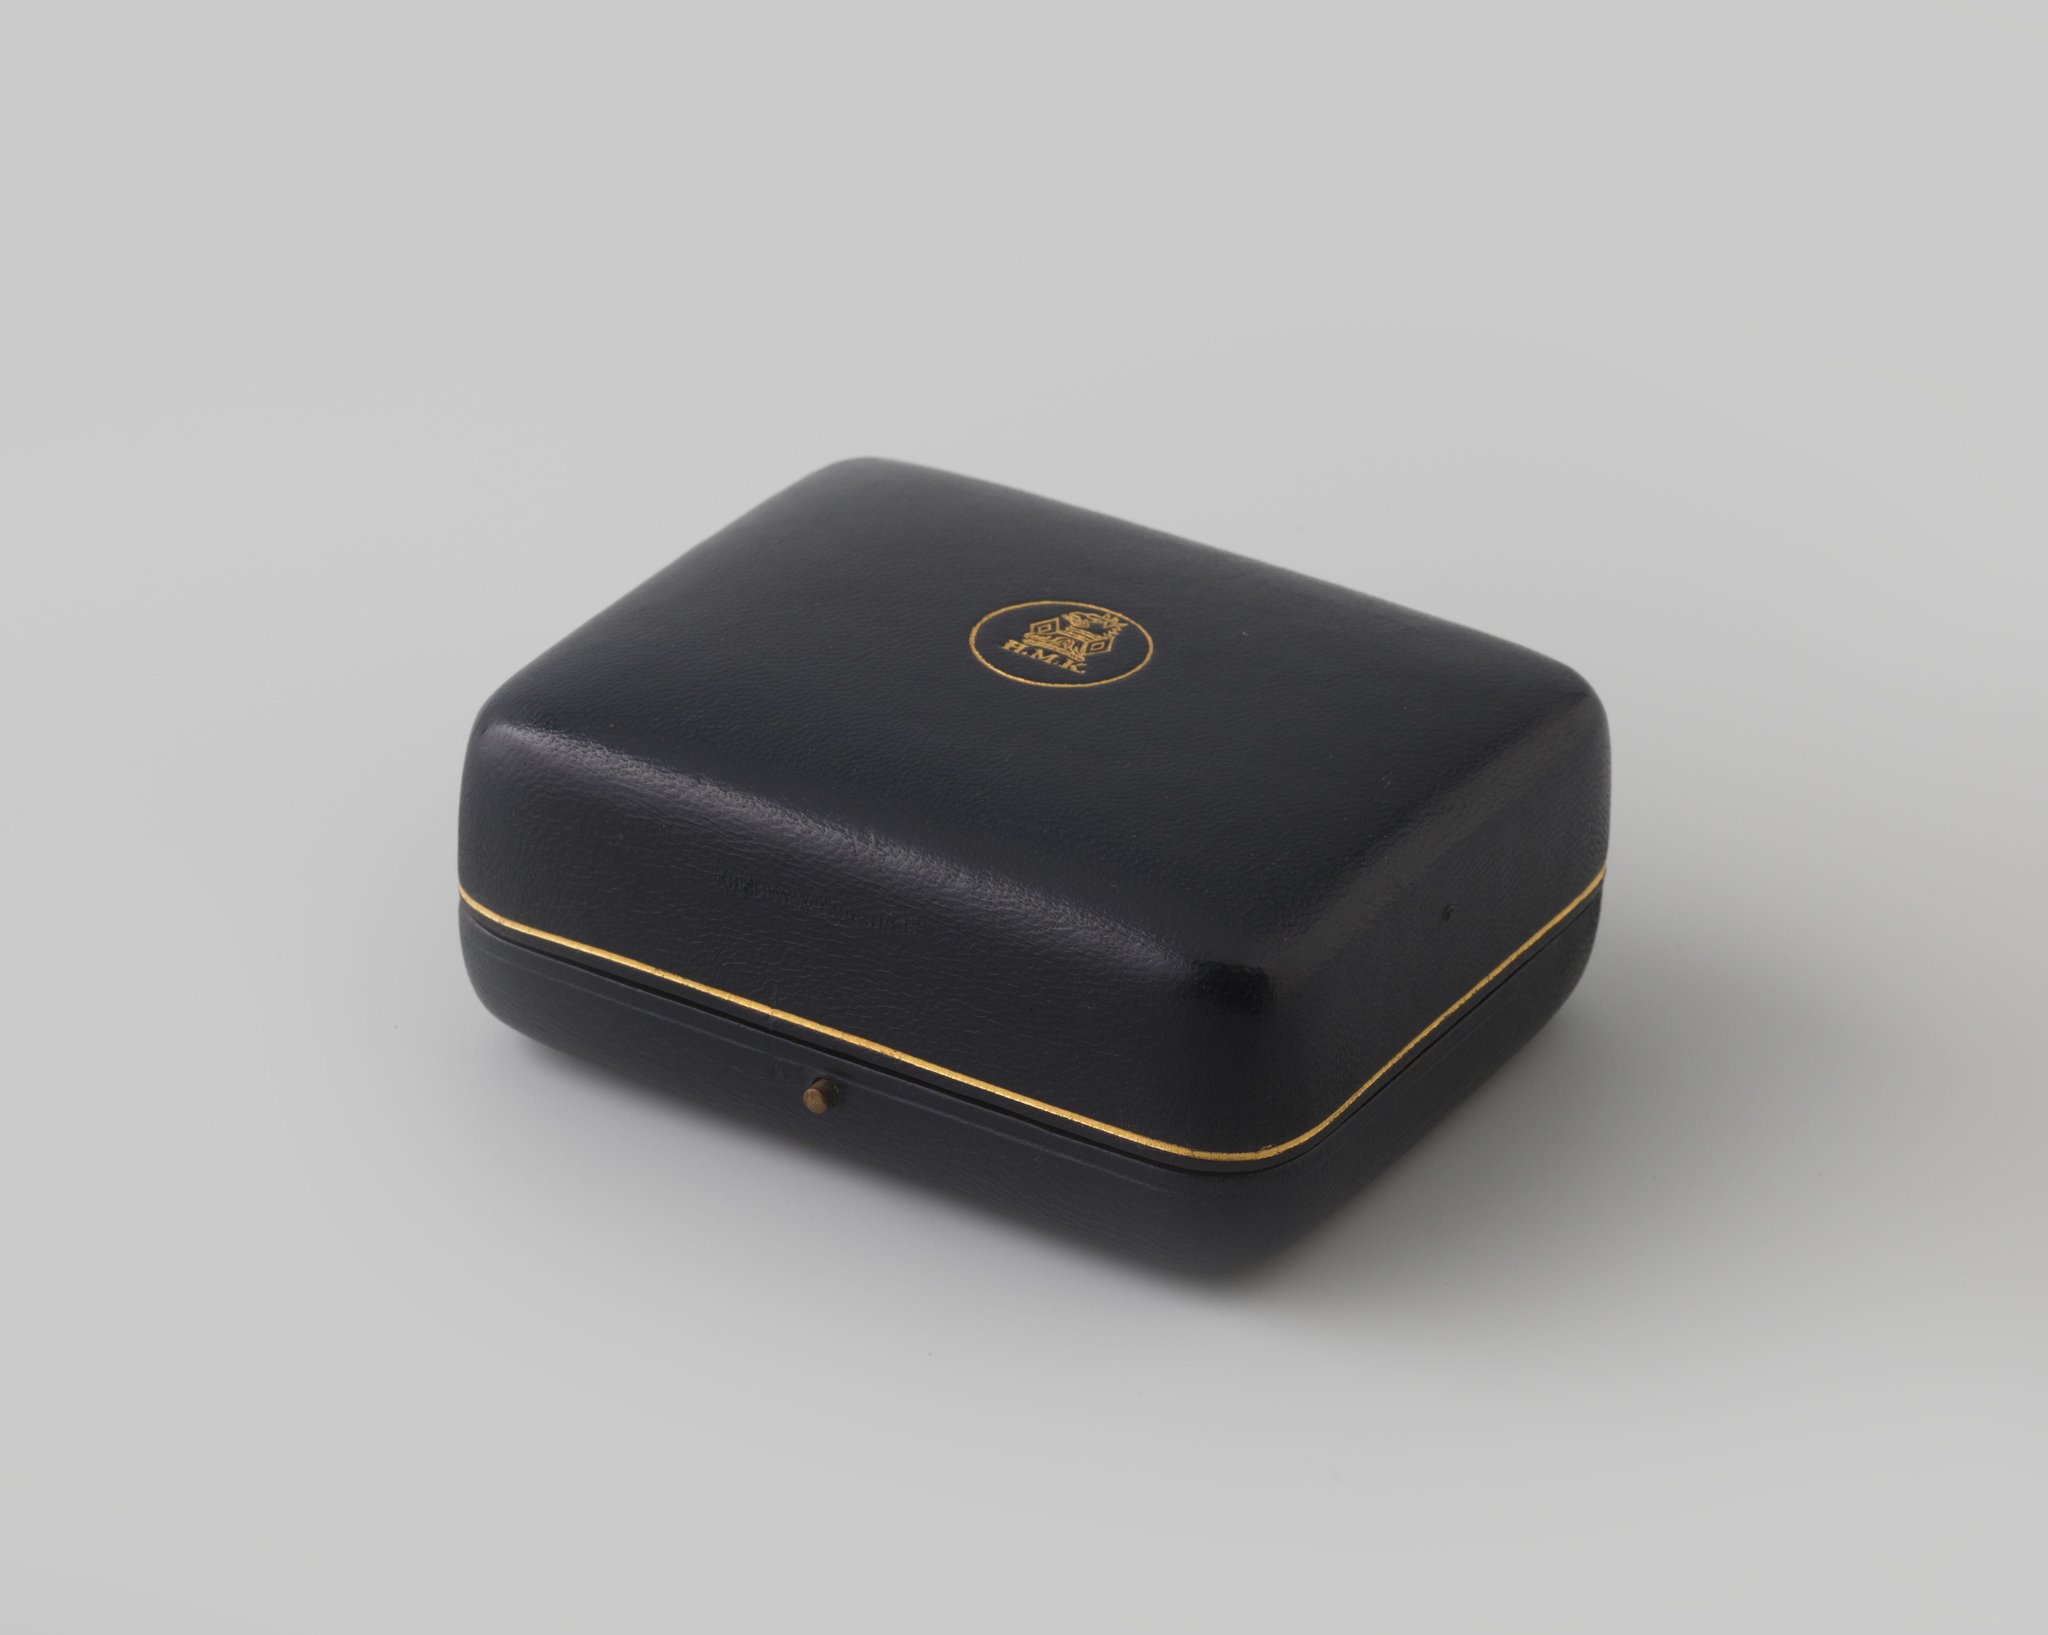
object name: case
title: Met blauw leer beklede juwelendoos voor snuifdoos van goud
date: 1739-1959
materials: leather, velvet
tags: fantasy ornament, colonnade, garden fountain, ornament ~ cartouche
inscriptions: town mark, duty mark, alloy mark, maker's mark, date letter: ‘E’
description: Met blauw leer beklede juwelendoos. Op het deksel een gouden wapen met daaronder H.M.K.